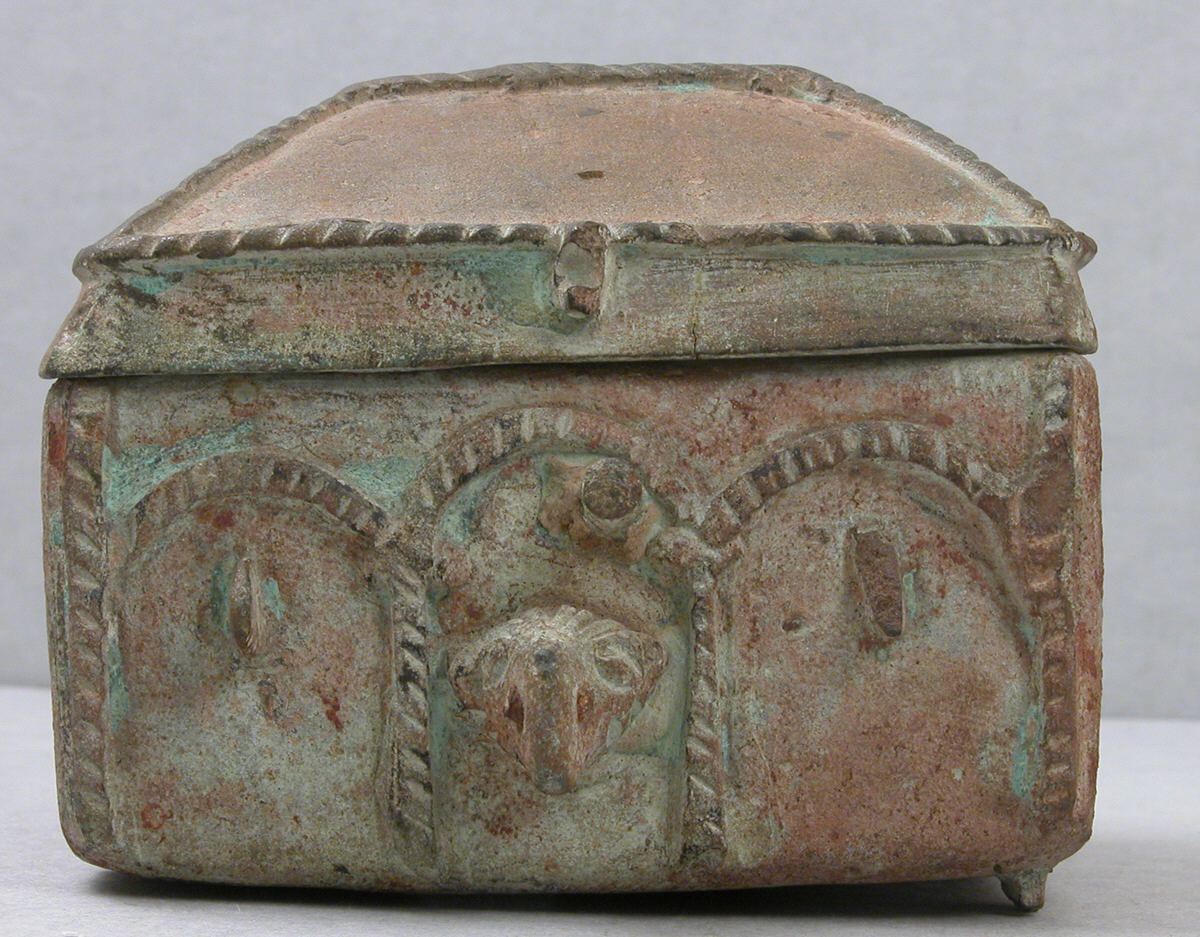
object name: casket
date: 201-1200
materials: bronze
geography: egypt